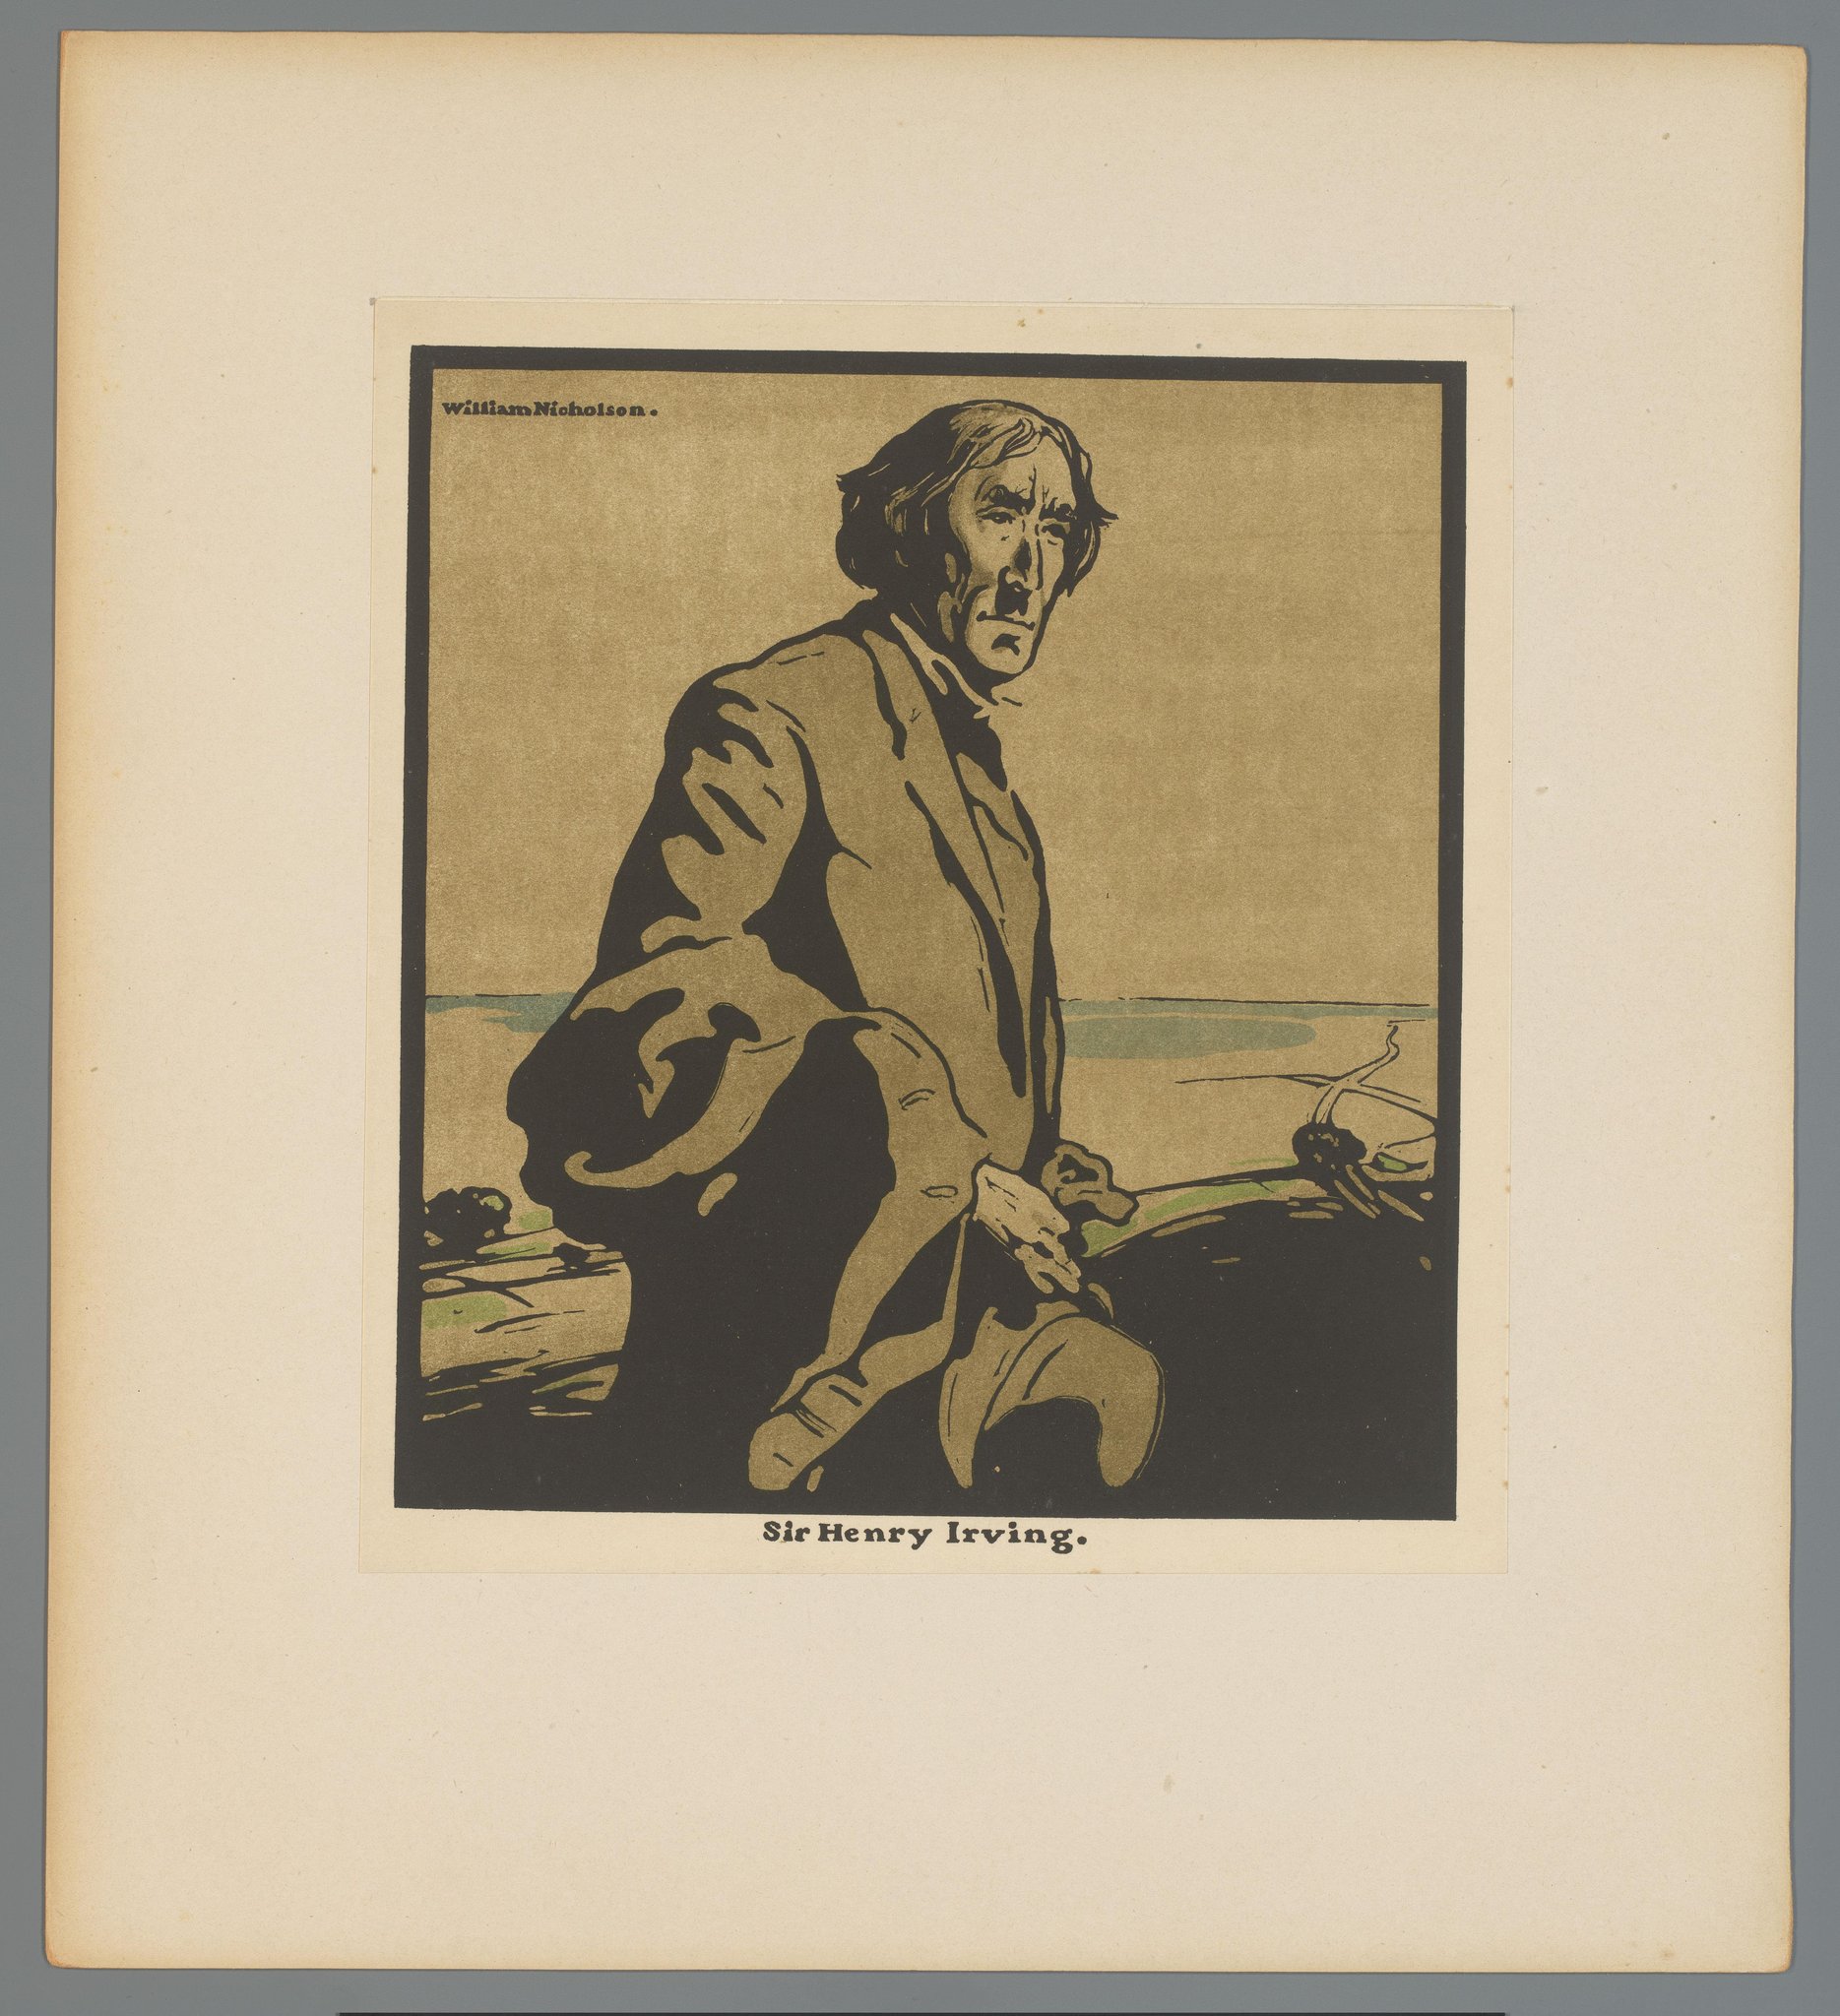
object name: print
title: Douze Portraits par William Nicholson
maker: henri floury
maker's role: publisher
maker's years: 1862-1961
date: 1900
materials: paper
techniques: lithograph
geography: paris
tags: historical persons, portrait of actor, actress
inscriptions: collector's mark: Lugt 2760, collector's mark: Lugt 2228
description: De serie met lithografieën is gemaakt naar ontwerpen van houtsneden door William Nicholson.